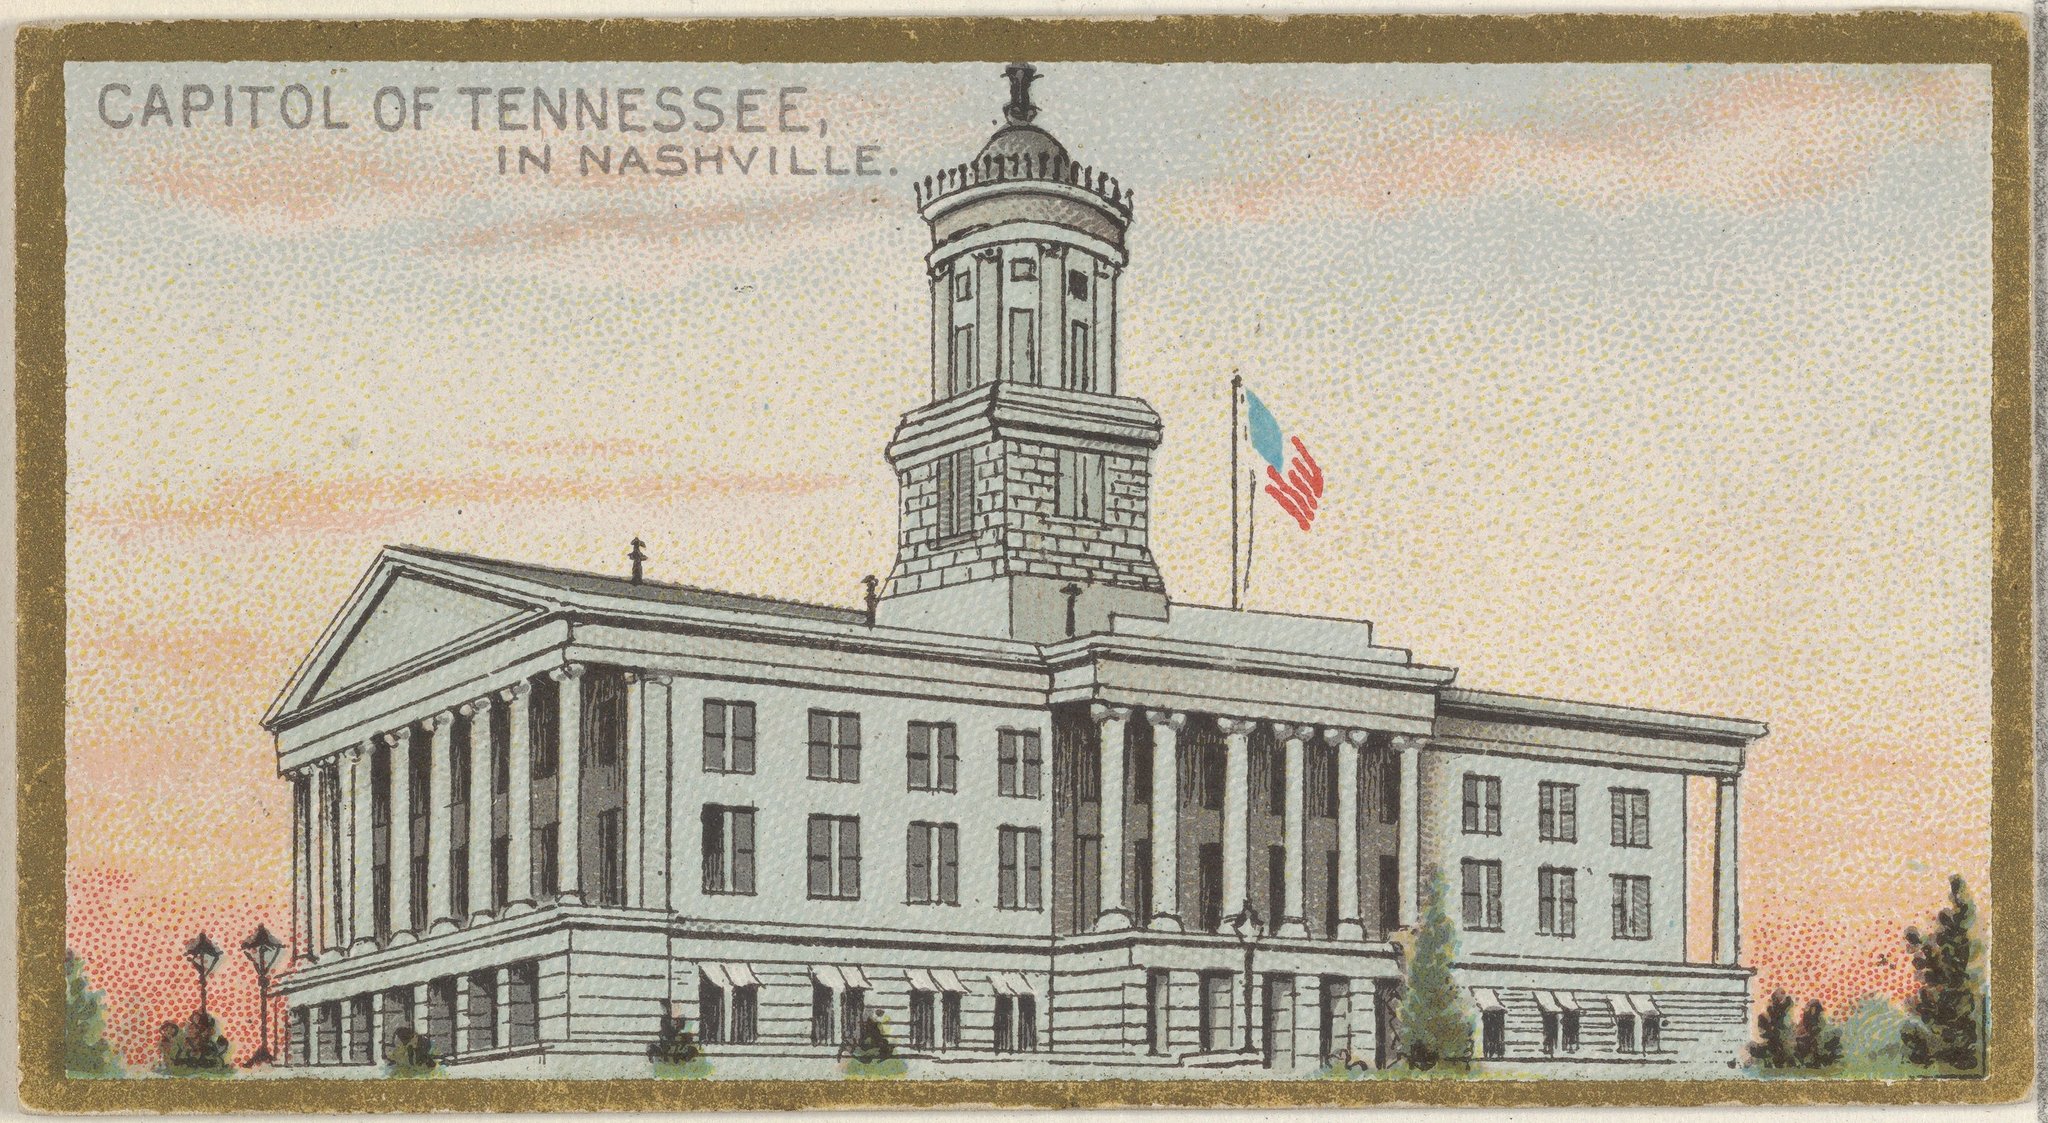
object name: print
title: Capitol of Tennessee in Nashville, from the General Government and State Capitol Buildings series (N14) for Allen & Ginter Cigarettes Brands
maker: allen & ginter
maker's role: publisher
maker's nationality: american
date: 1889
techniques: color lithograph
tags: buildings,flags